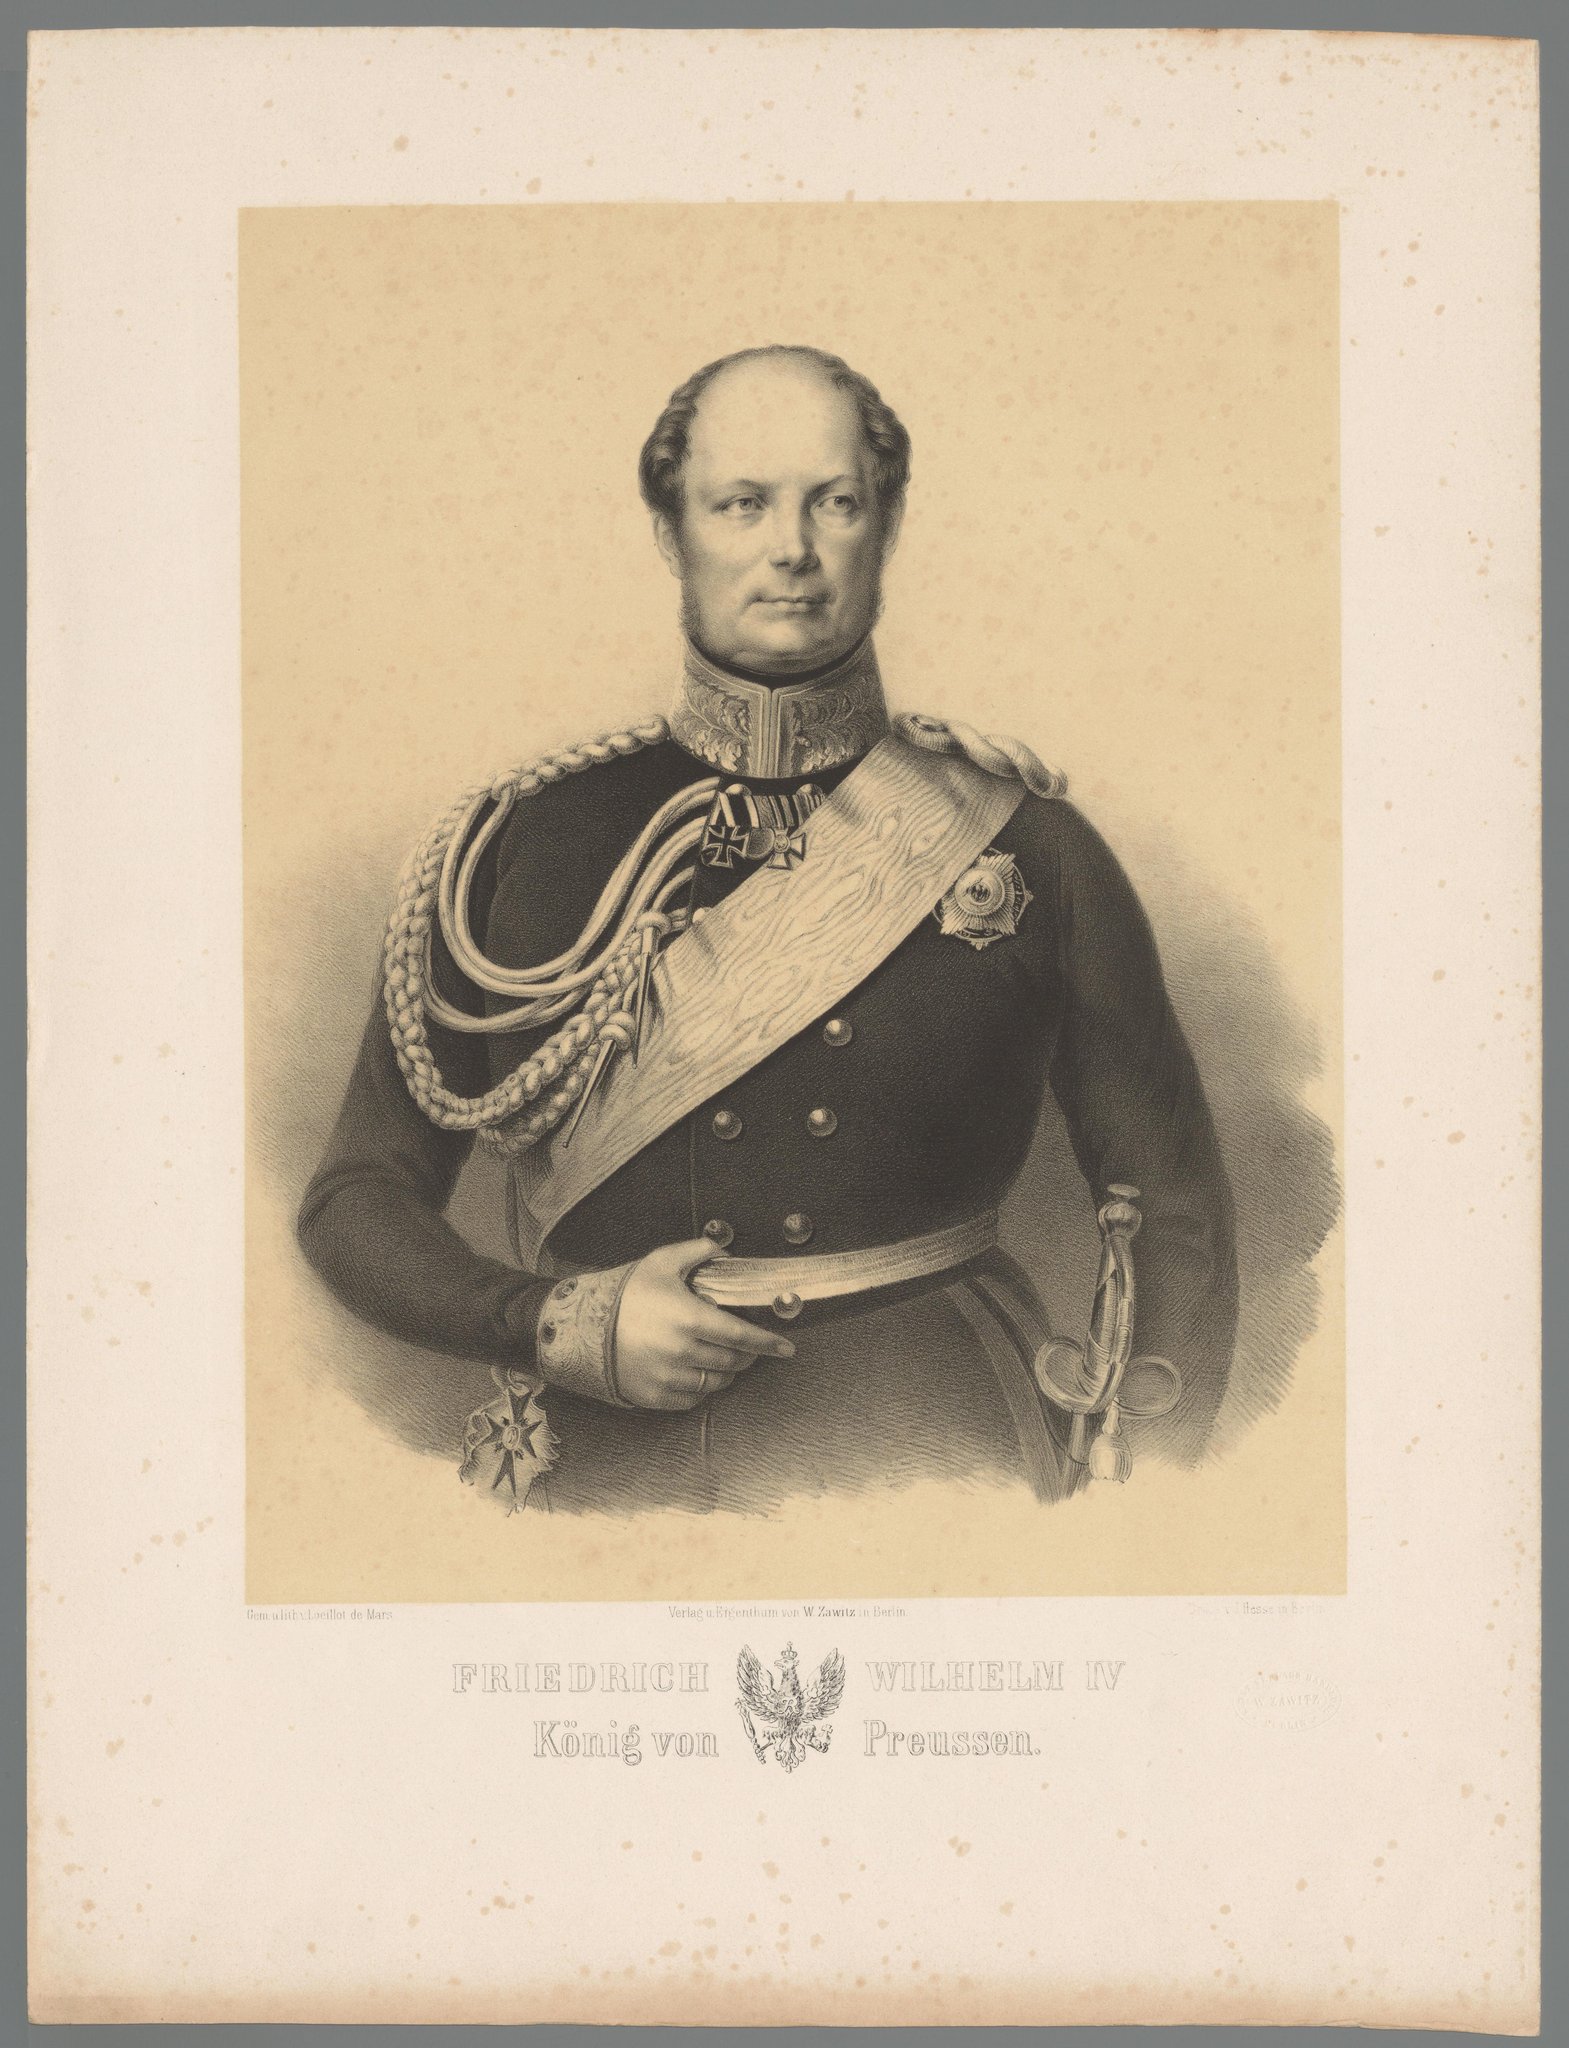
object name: print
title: Friedrich Wilhelm IV König von Preussen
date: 1832-1871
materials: paper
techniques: tone lithography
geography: berlin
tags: frederik willem iv (koning van pruisen), historical persons, king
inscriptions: check stamp: Lugt 4861, collector's mark: Lugt 2228